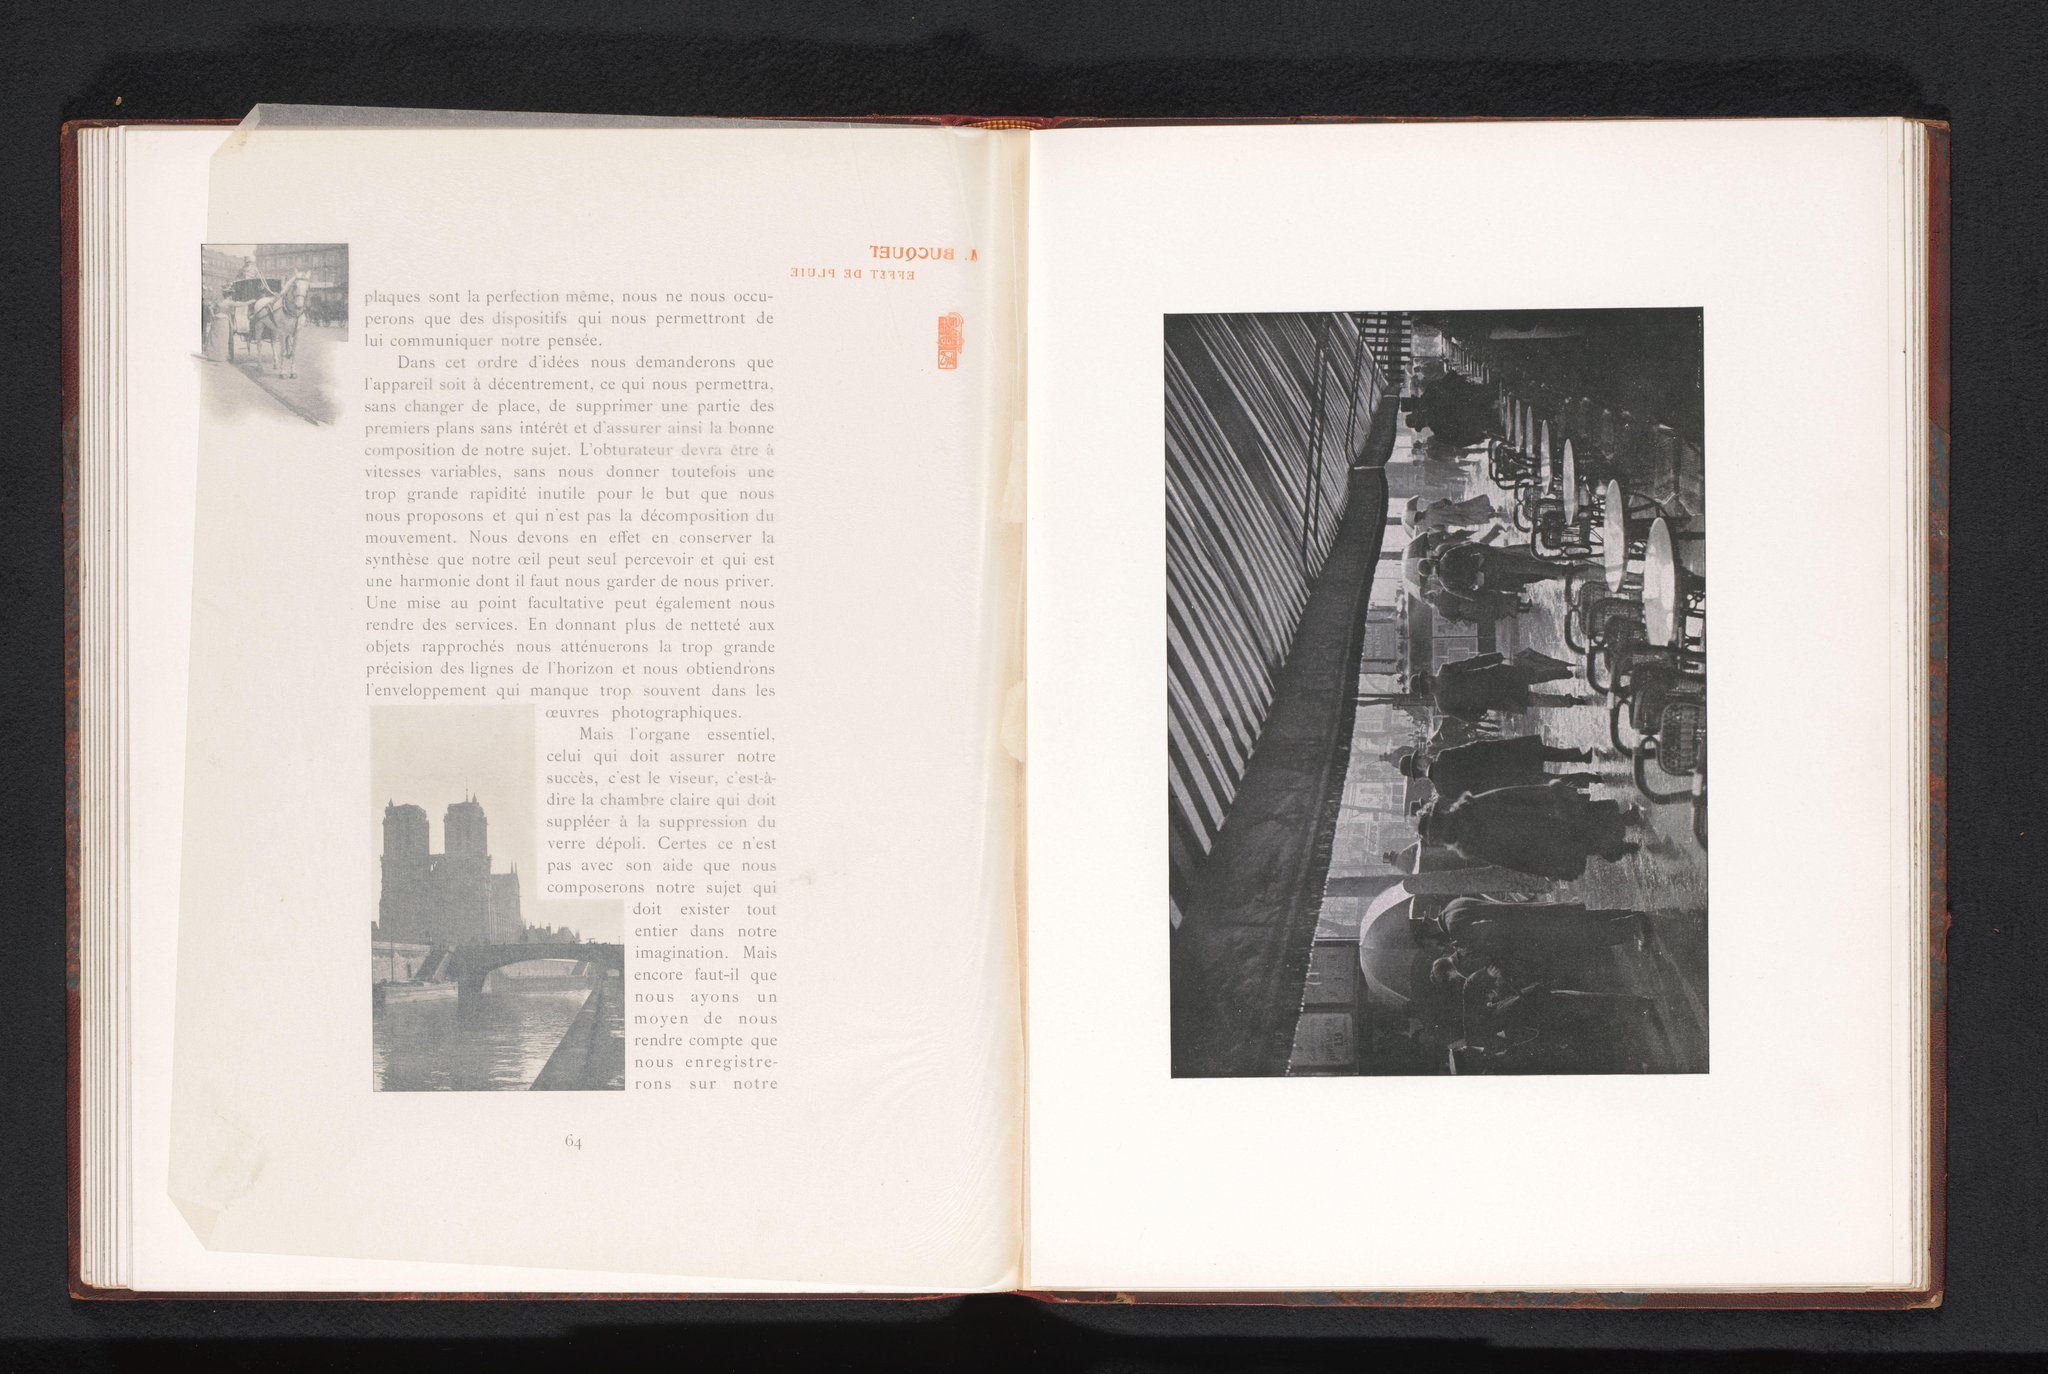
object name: photomechanical print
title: Mensen op straat in de regen, gezien vanaf een terras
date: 1895-1900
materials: paper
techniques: autotype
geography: brussels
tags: downpour, rain shower, adult man (+ more than eight persons), street